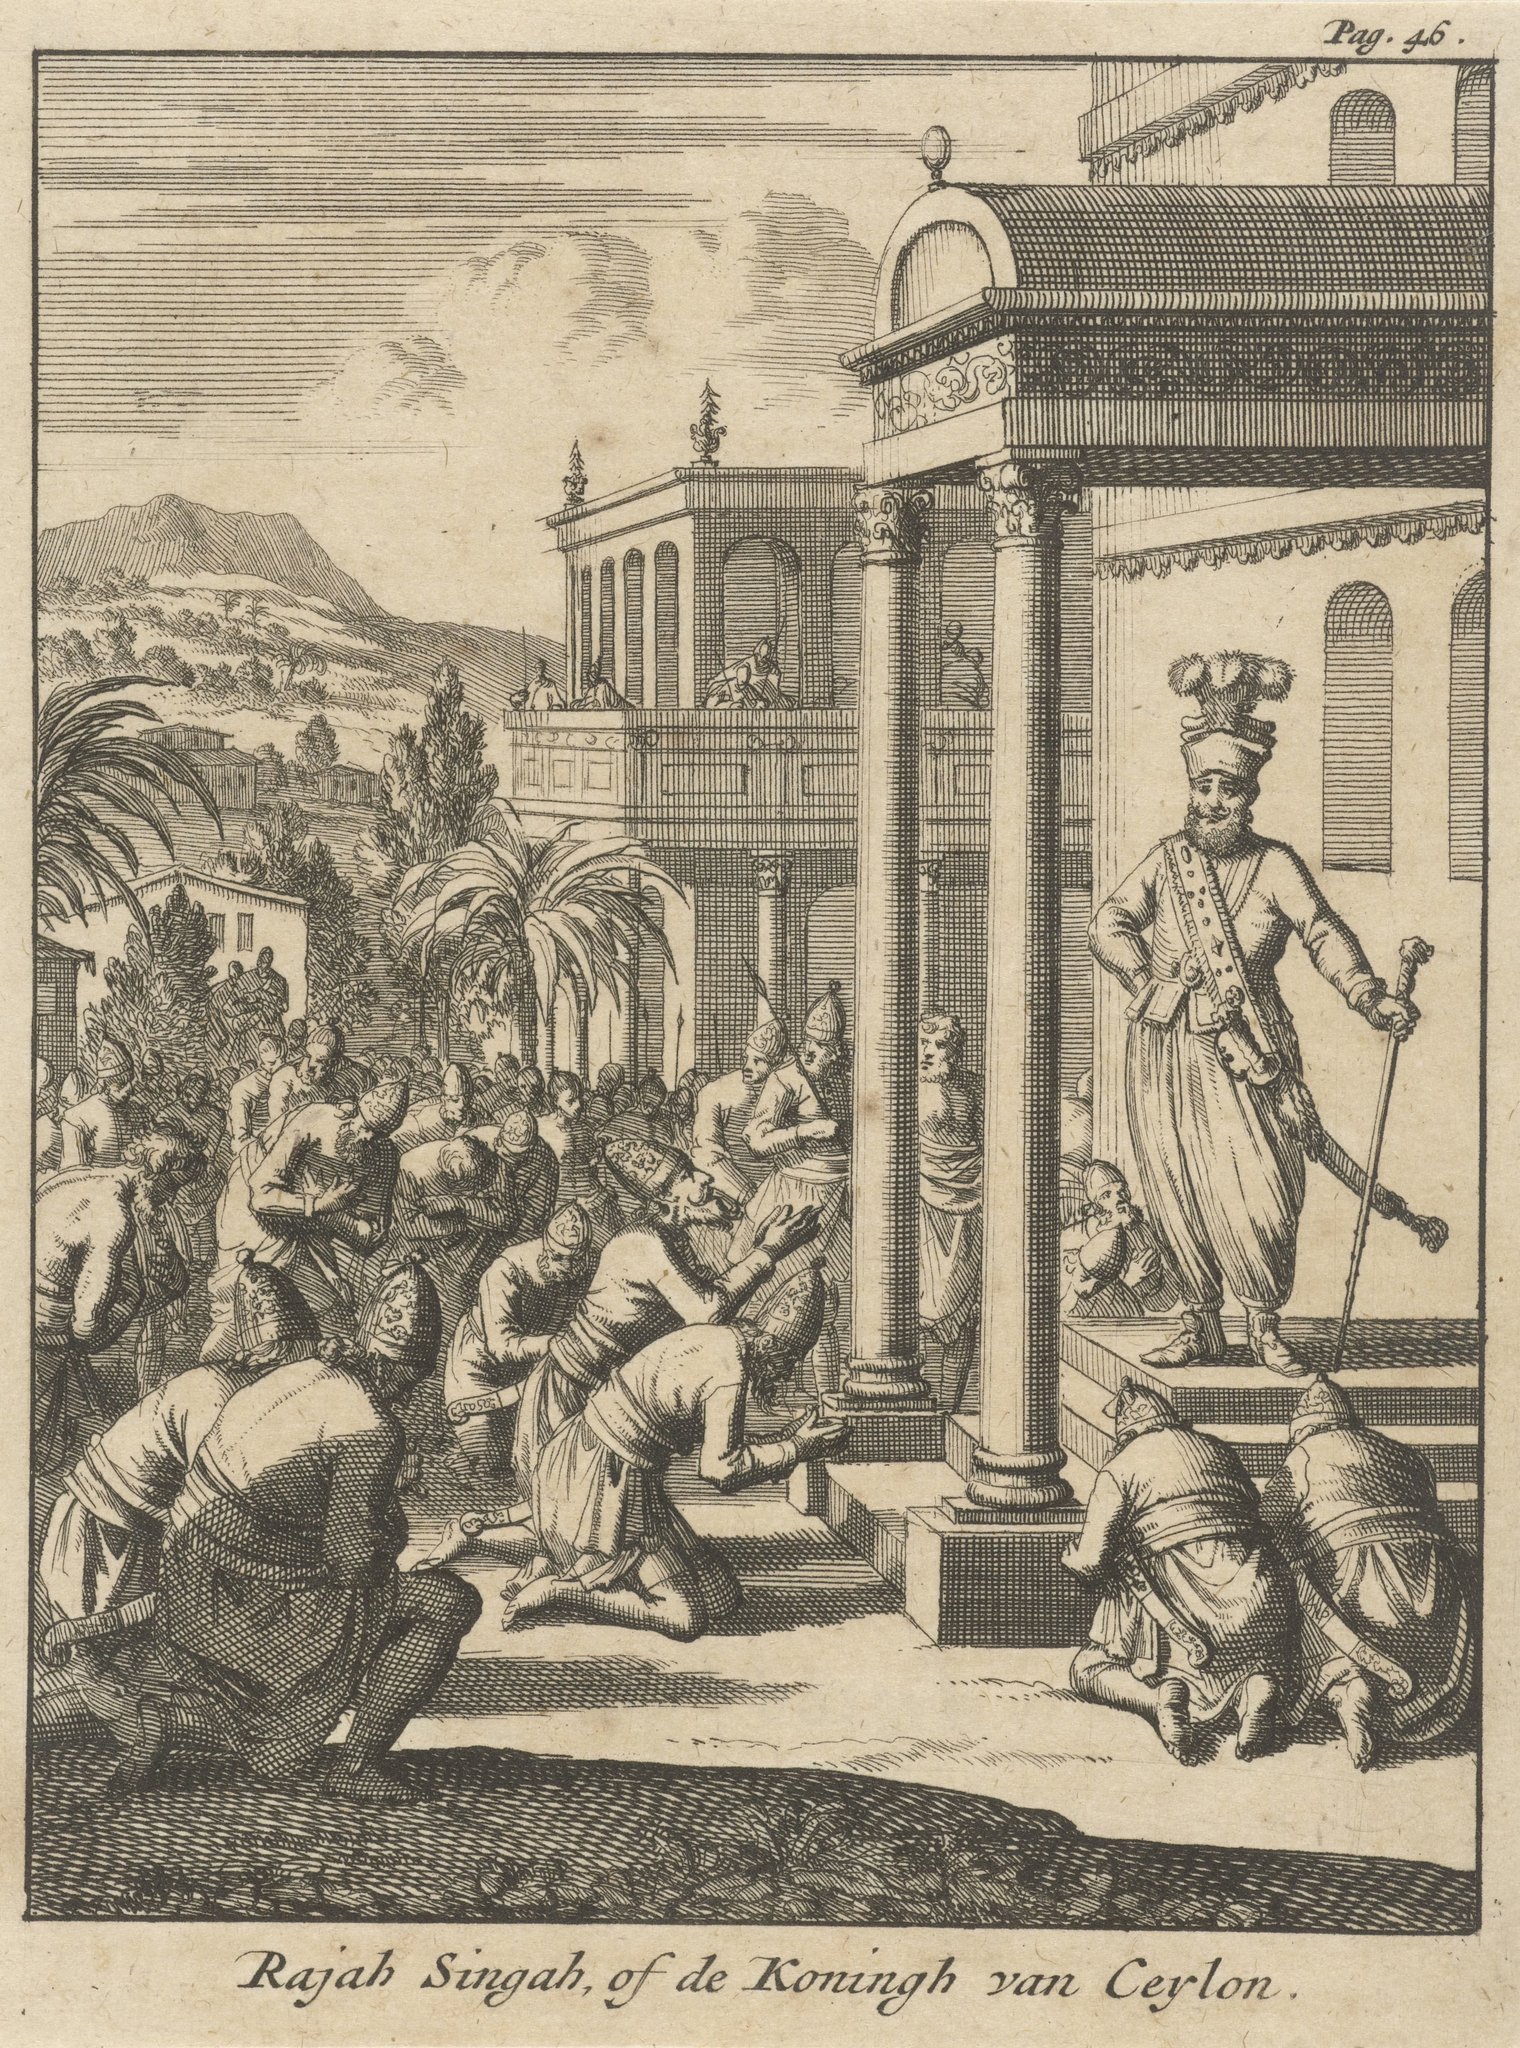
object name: book illustration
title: Onderdanen knielen voor de koning van Ceylon, Rajah Singah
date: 1692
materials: paper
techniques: etching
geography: amsterdam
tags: kneeling figure, king, sri lanka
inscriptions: collector's mark: Lugt 2228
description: Illustratie uit: Knox, Robert. t'Eyland Ceylon in sĳn binnenste, of't koningrijck Candy. Utrecht: Willem Broedelet, 1692.